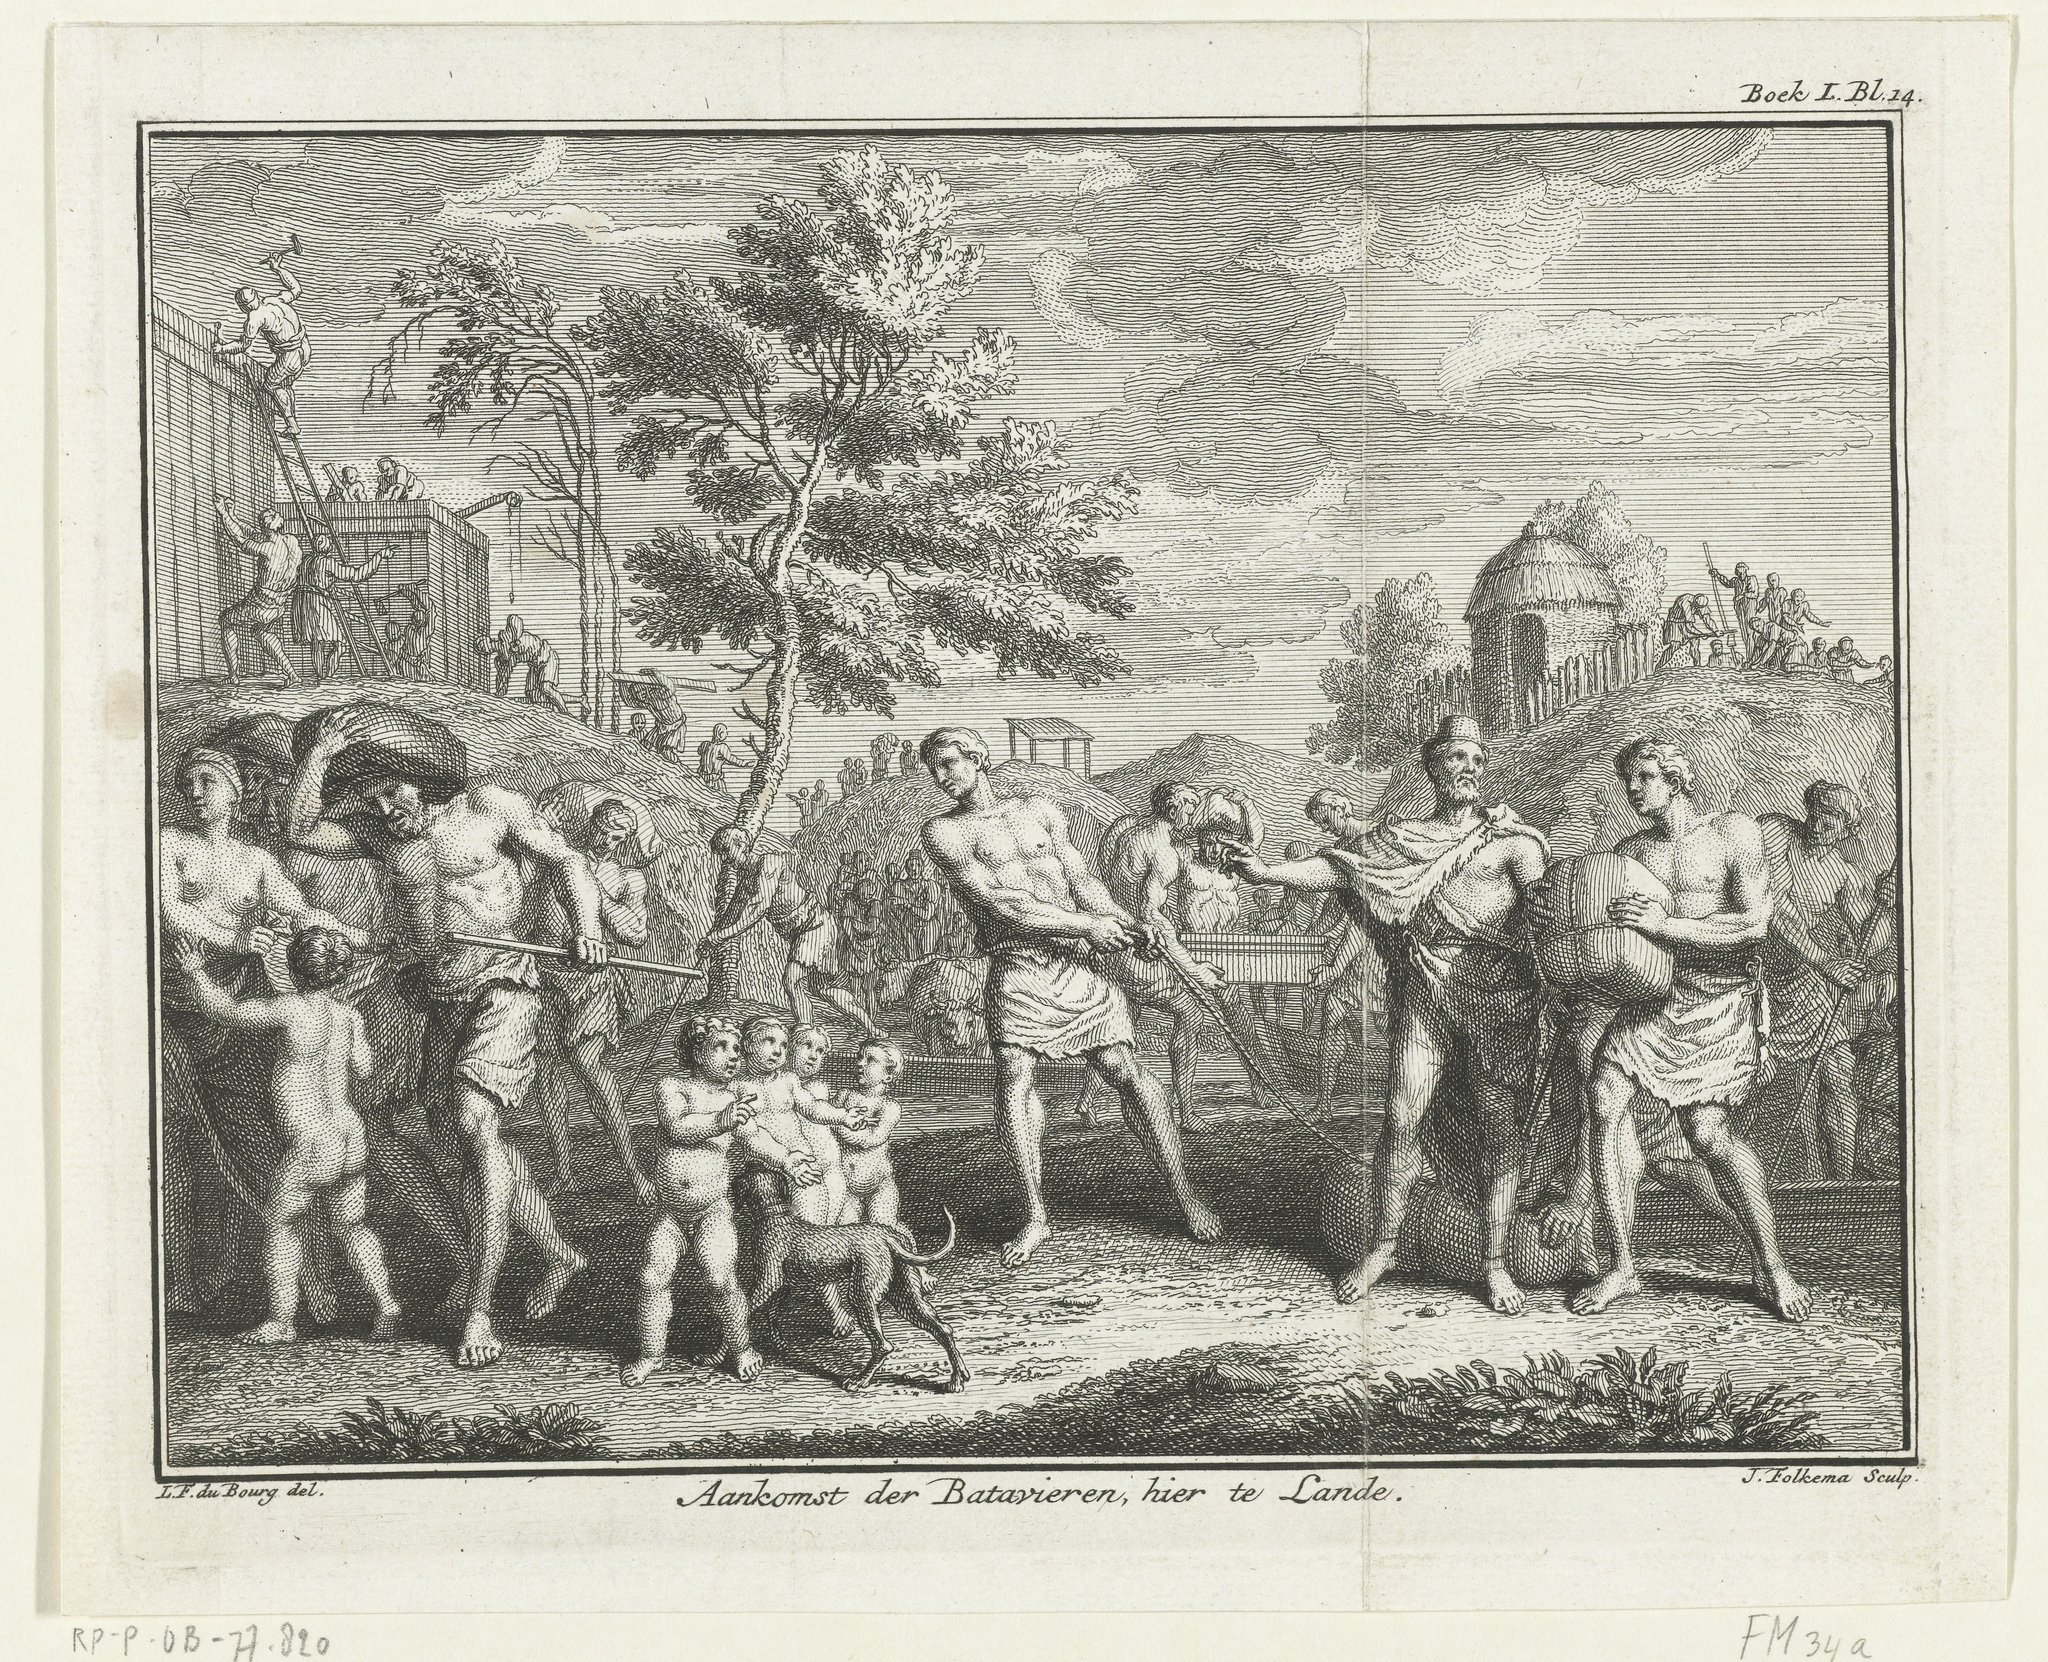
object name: history print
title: Aankomst van de Bataven in Nederland, ca. 55-10 v.C.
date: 1747-1749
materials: paper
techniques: engraving, etching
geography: netherlands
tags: extinct, 'historical' peoples (with name), netherlands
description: Illustratie voor: Jan Wagenaar, Vaderlandsche historie, Amsterdam 1749-1759, boek I, blz. 14.